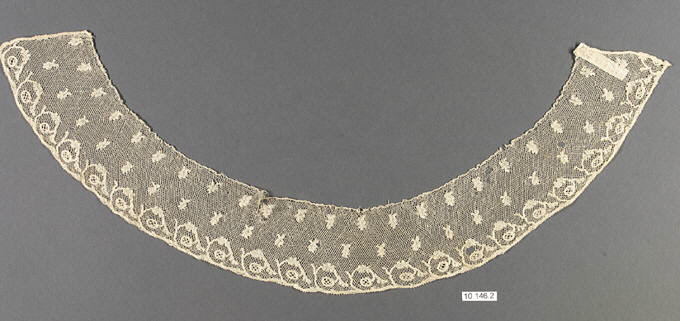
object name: strip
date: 1701-1800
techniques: lace